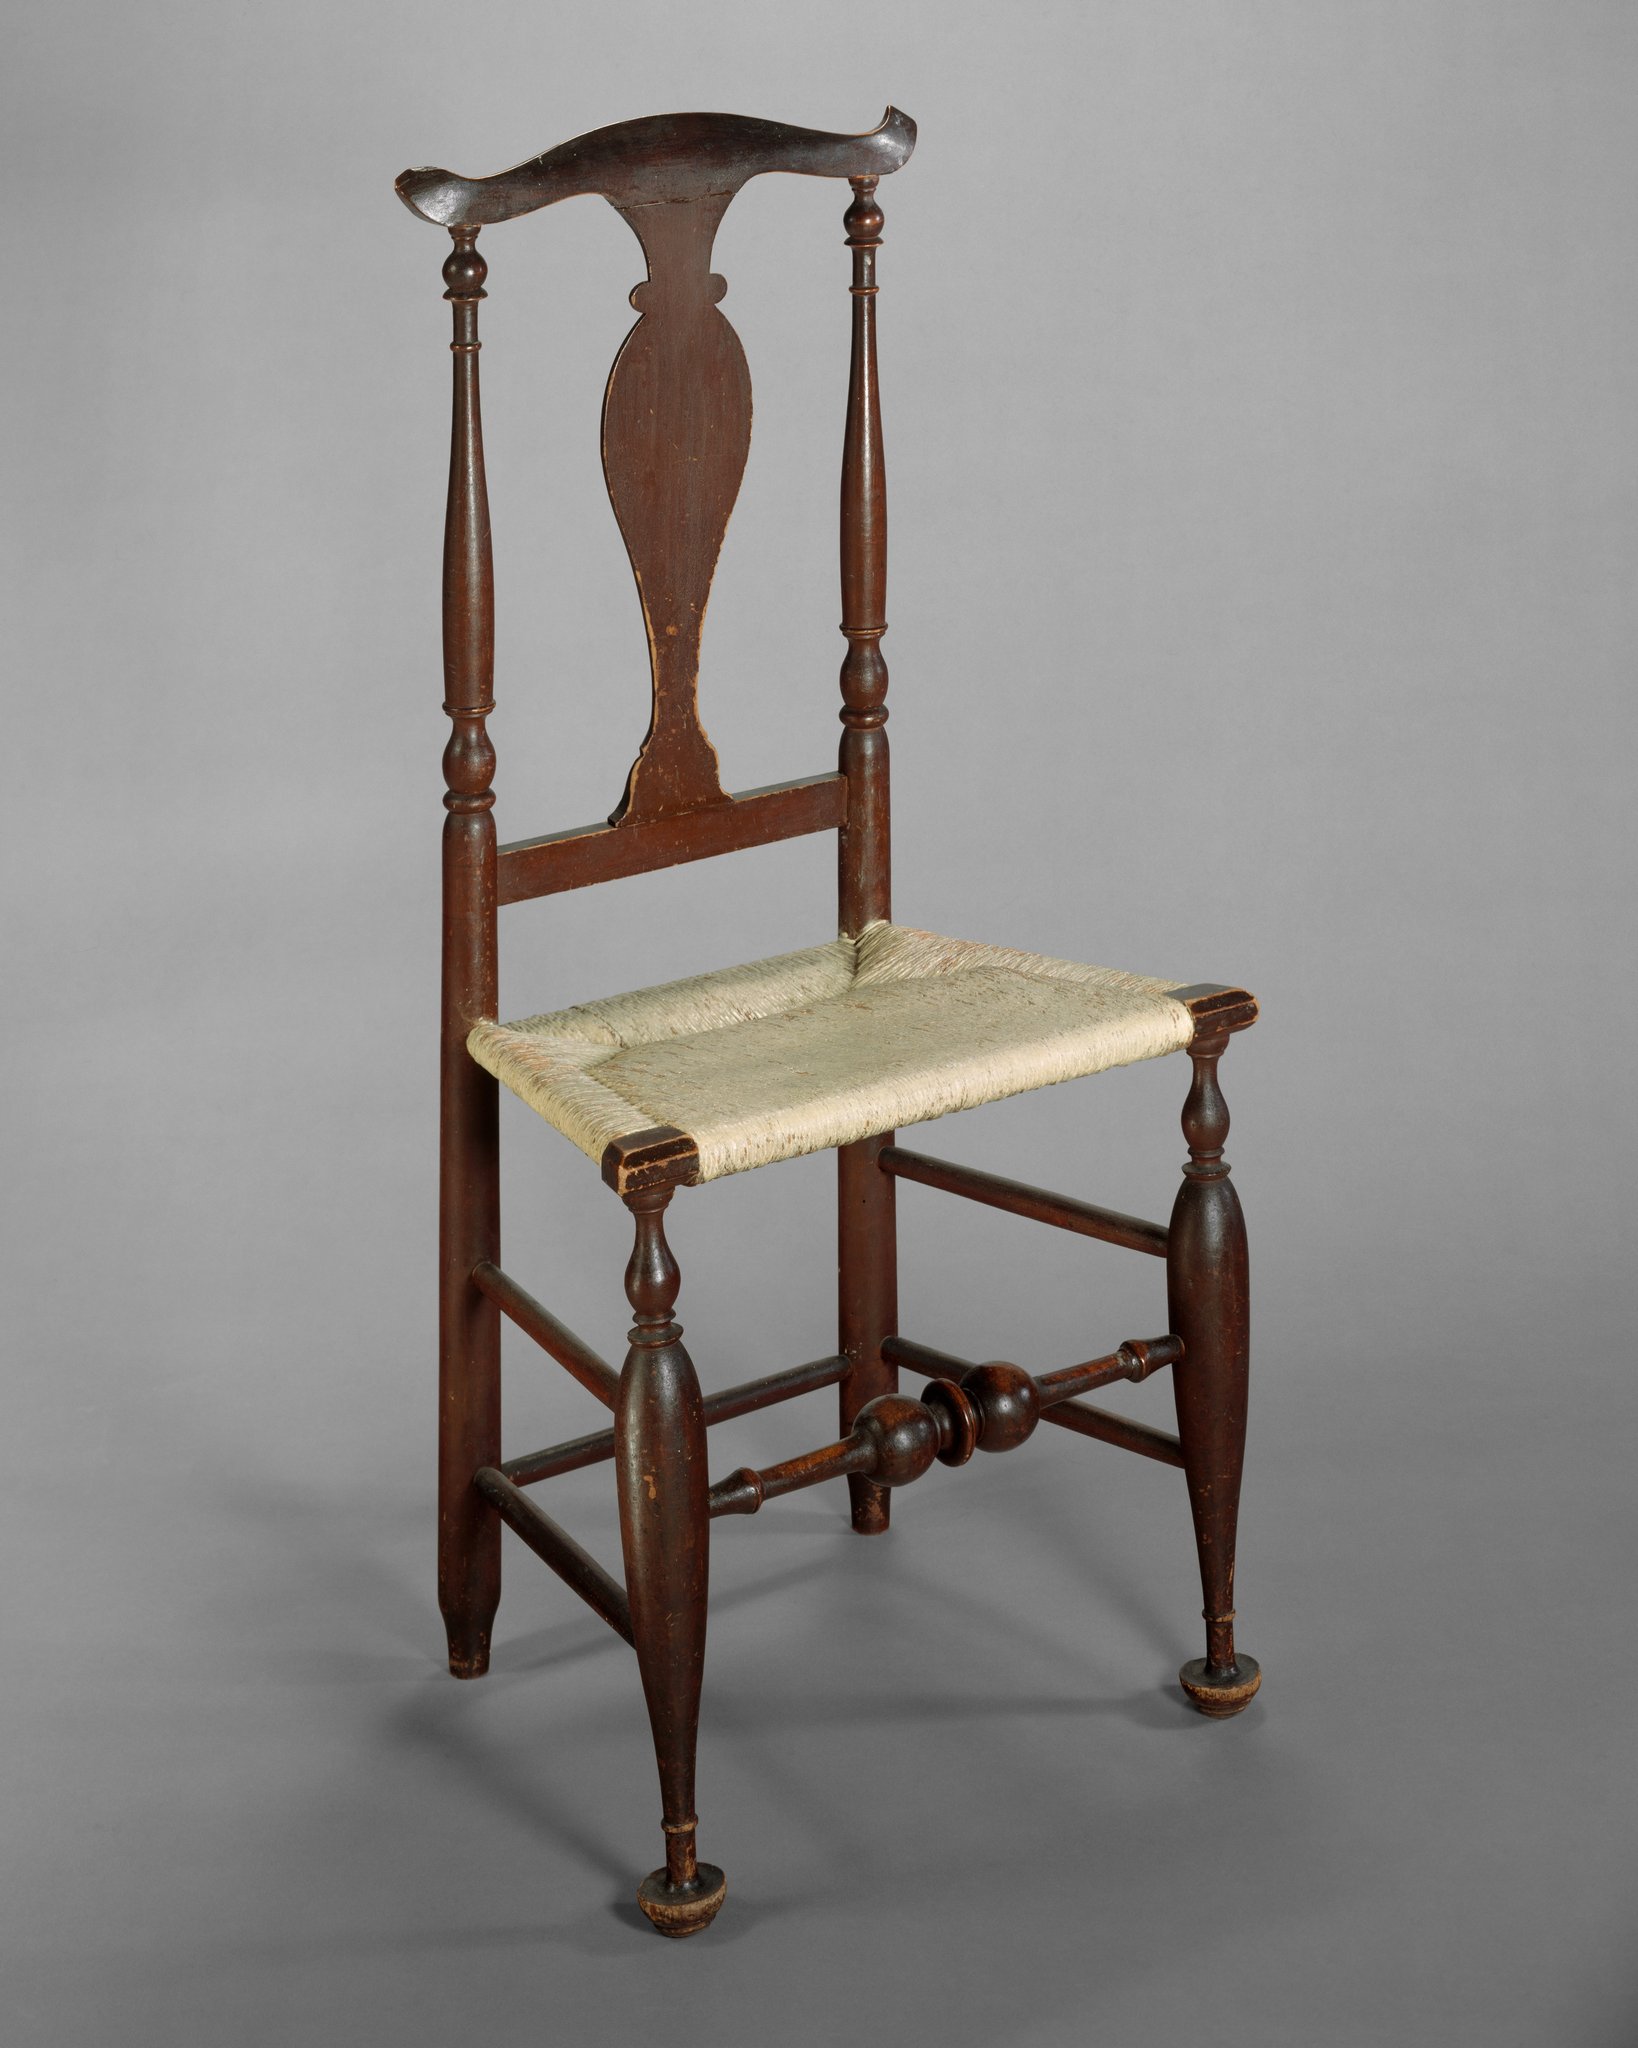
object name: side chair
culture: american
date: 1770-1800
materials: wood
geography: united states